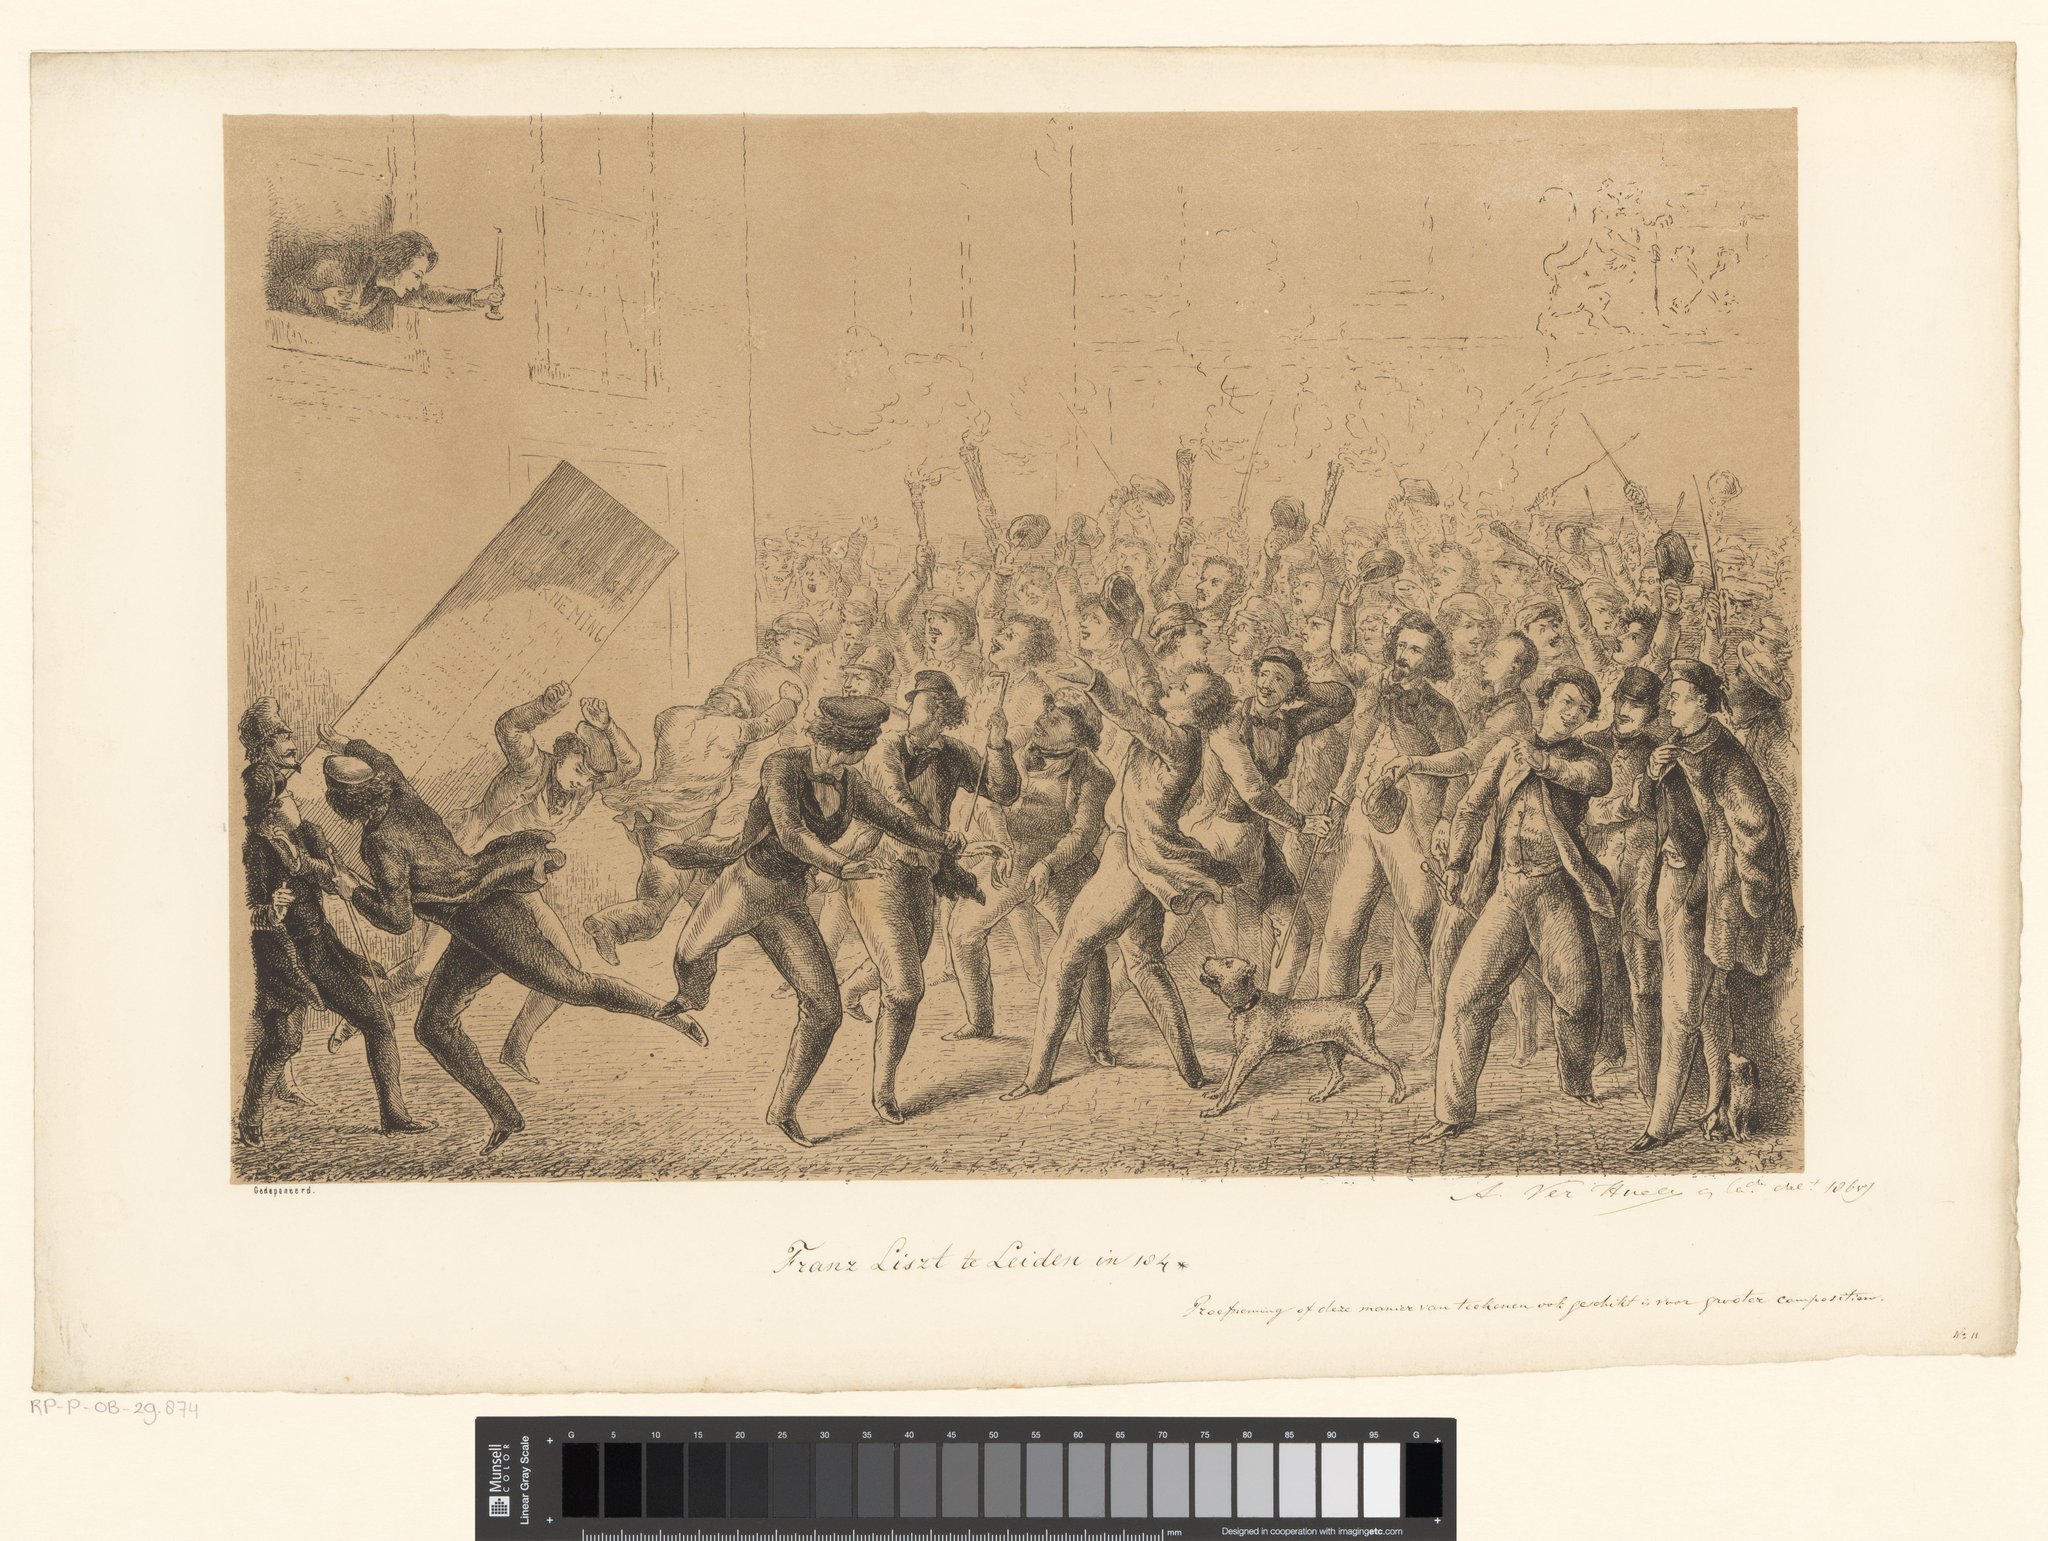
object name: print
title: Franz Liszt te Leiden in 184*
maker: alexander ver huell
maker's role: draughtsman, print maker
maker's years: 1822-1897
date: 1864-1866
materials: paper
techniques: tone lithography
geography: arnhem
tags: idolatry; 'idololatria', 'religione finta' (ripa), composer, leiden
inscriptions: collector's mark: Lugt 2228, : ‘Gedeponeerd.’, watermark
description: Componist en pianist Franz Liszt hangt met een kaars uit het raam tijdens zijn bezoek aan Leiden. Op straat staat een groep feestvierende studenten met fakkels die hun idool begroeten.